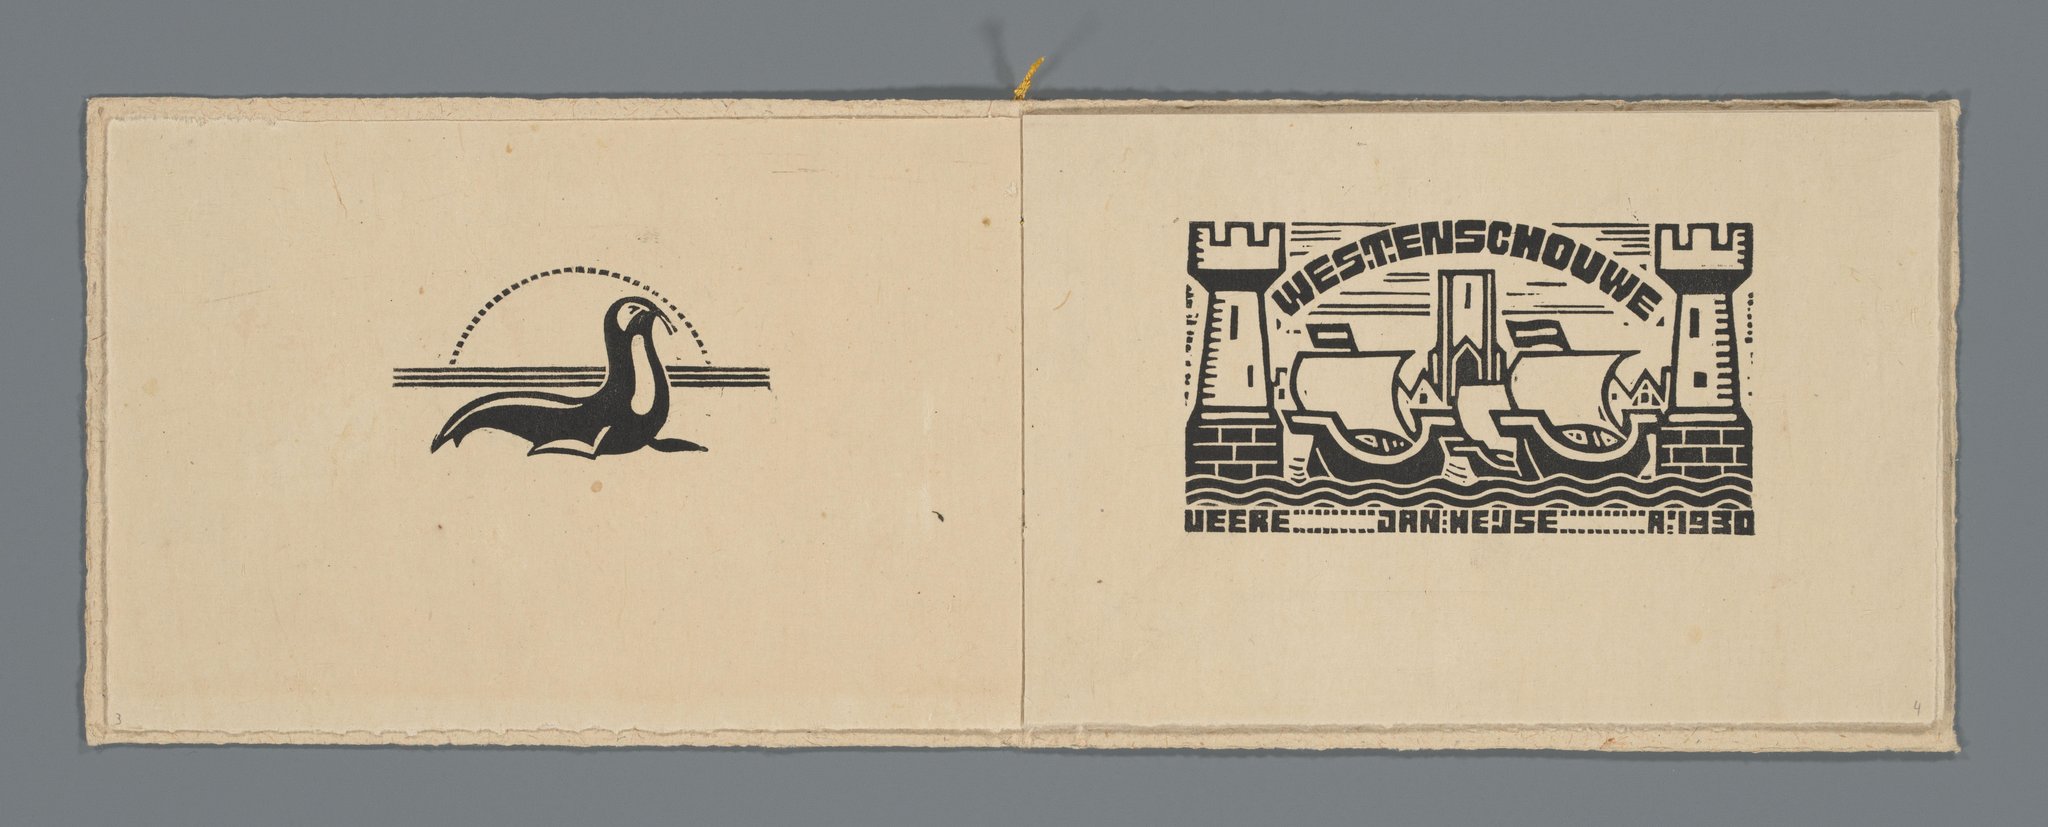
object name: print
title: Zeehond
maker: jan heyse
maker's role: painter, print maker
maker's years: 1882-1954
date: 1930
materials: paper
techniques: woodcut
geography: veere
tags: swimming mammals: seal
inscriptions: date